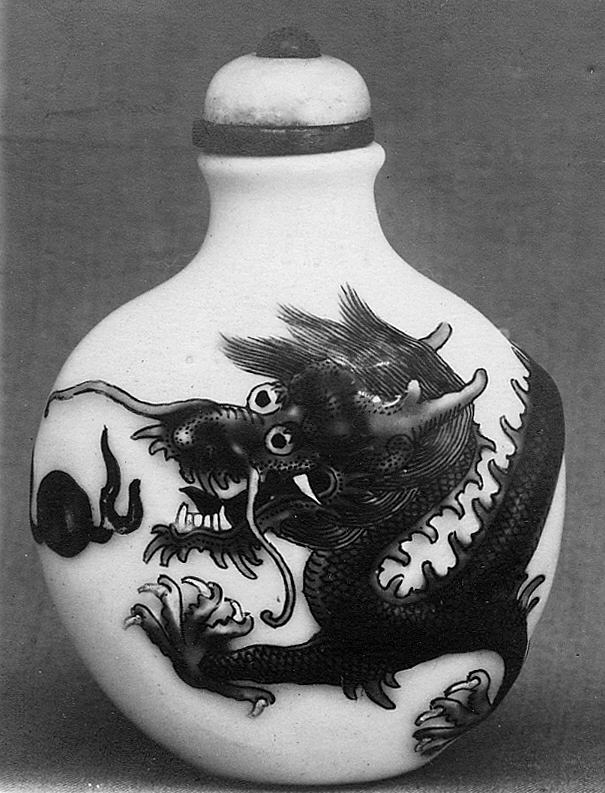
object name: snuff bottle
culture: chinese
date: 1821-1850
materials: porcelain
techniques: molding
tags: dragons